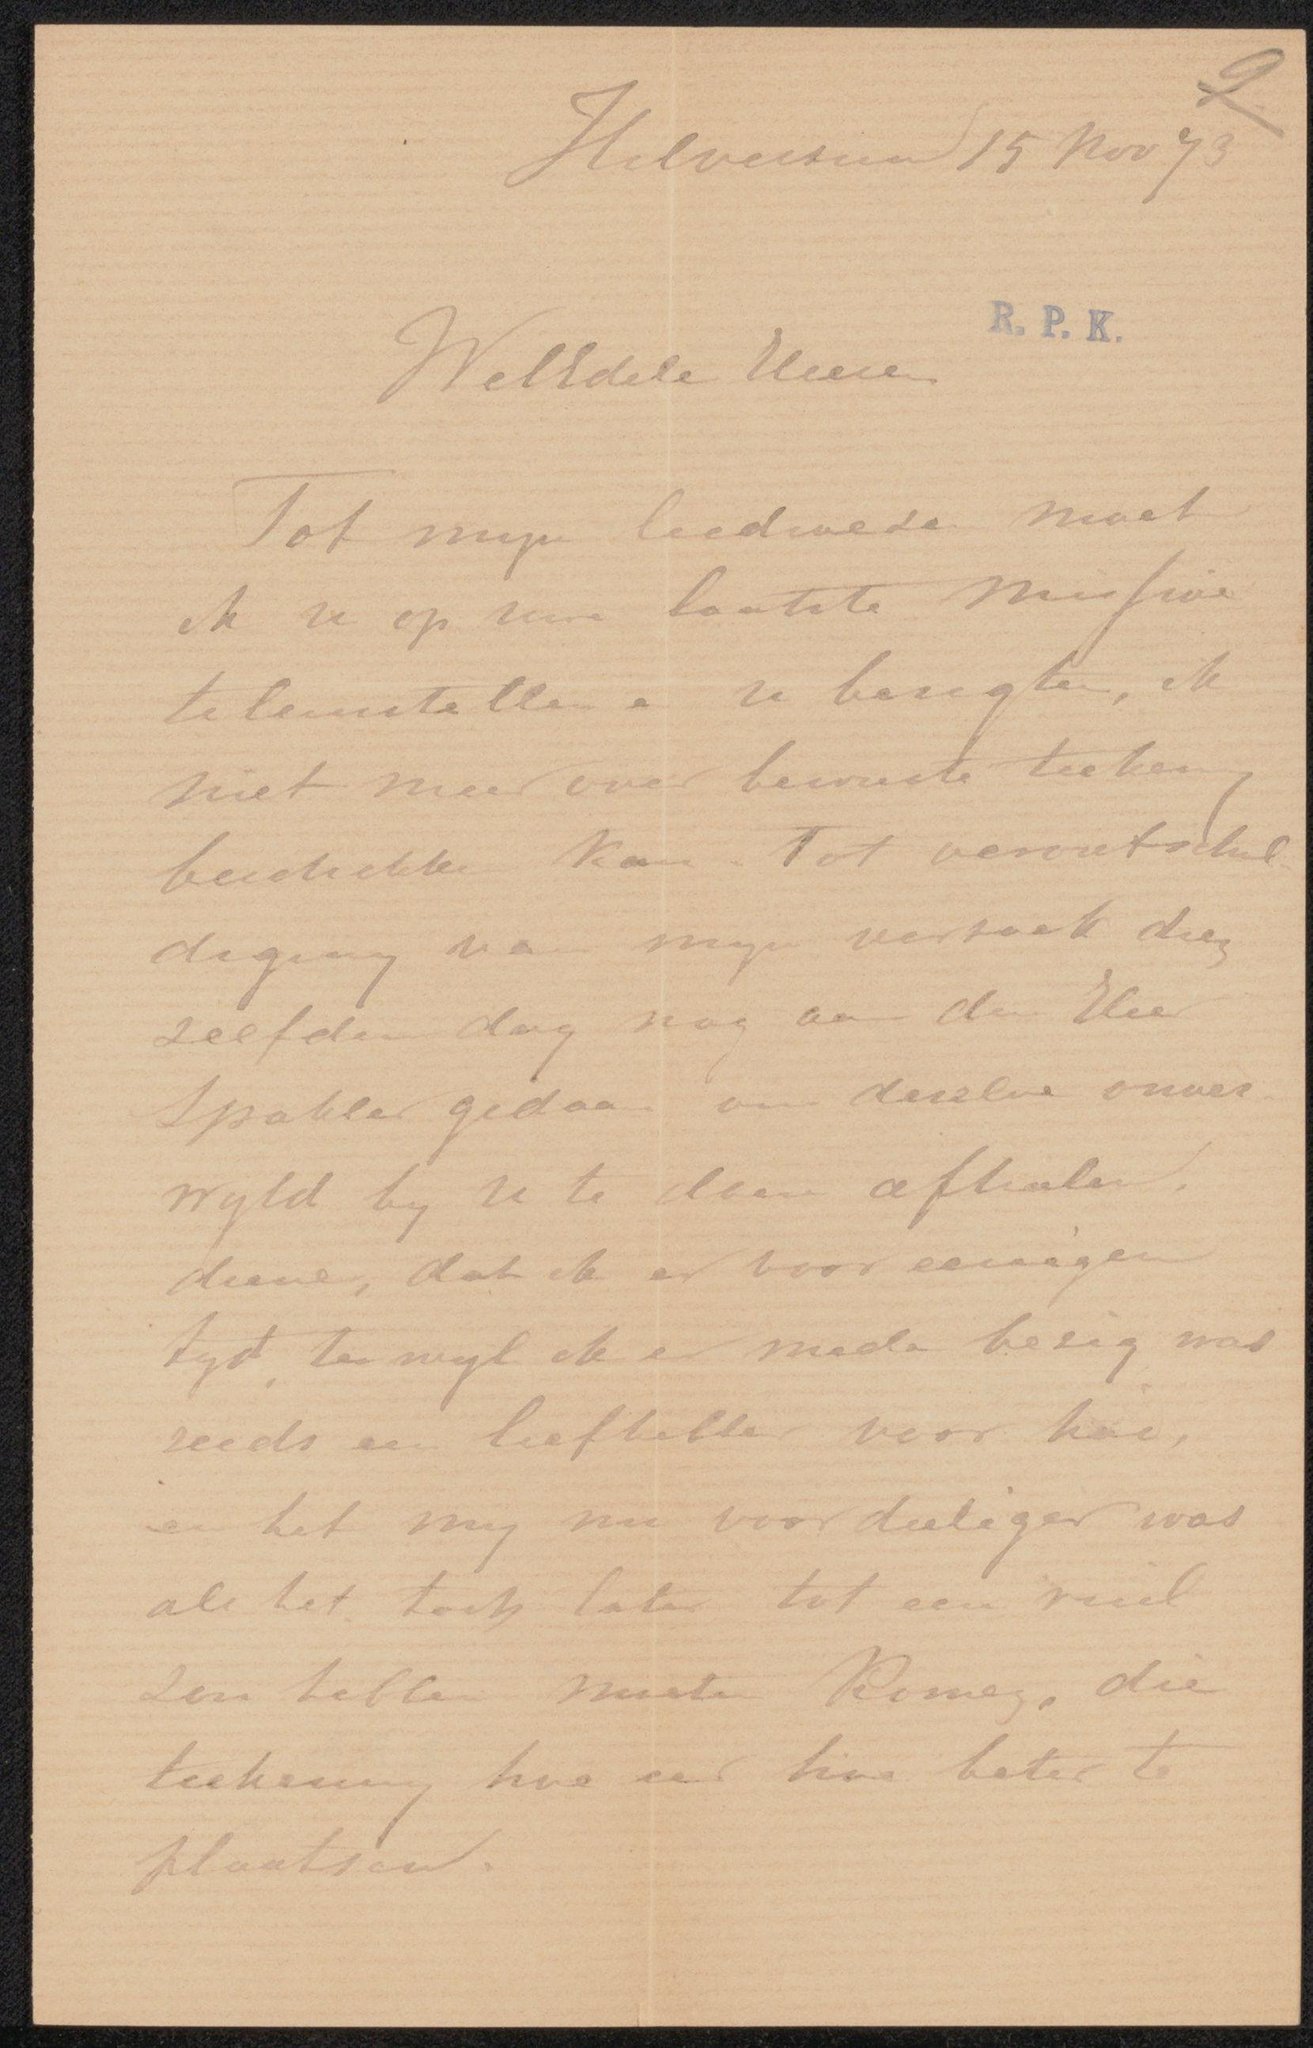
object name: letter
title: Brief aan Frans Buffa en Zonen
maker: hendrik albert van trigt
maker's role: draughtsman, painter, print maker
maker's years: 1829-1899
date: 1873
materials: ink, paper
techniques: pen, writing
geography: hilversum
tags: publisher, art trade, art shop, drawing, painting (including book-illumination, miniature-painting)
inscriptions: collector's mark: Lugt 2233